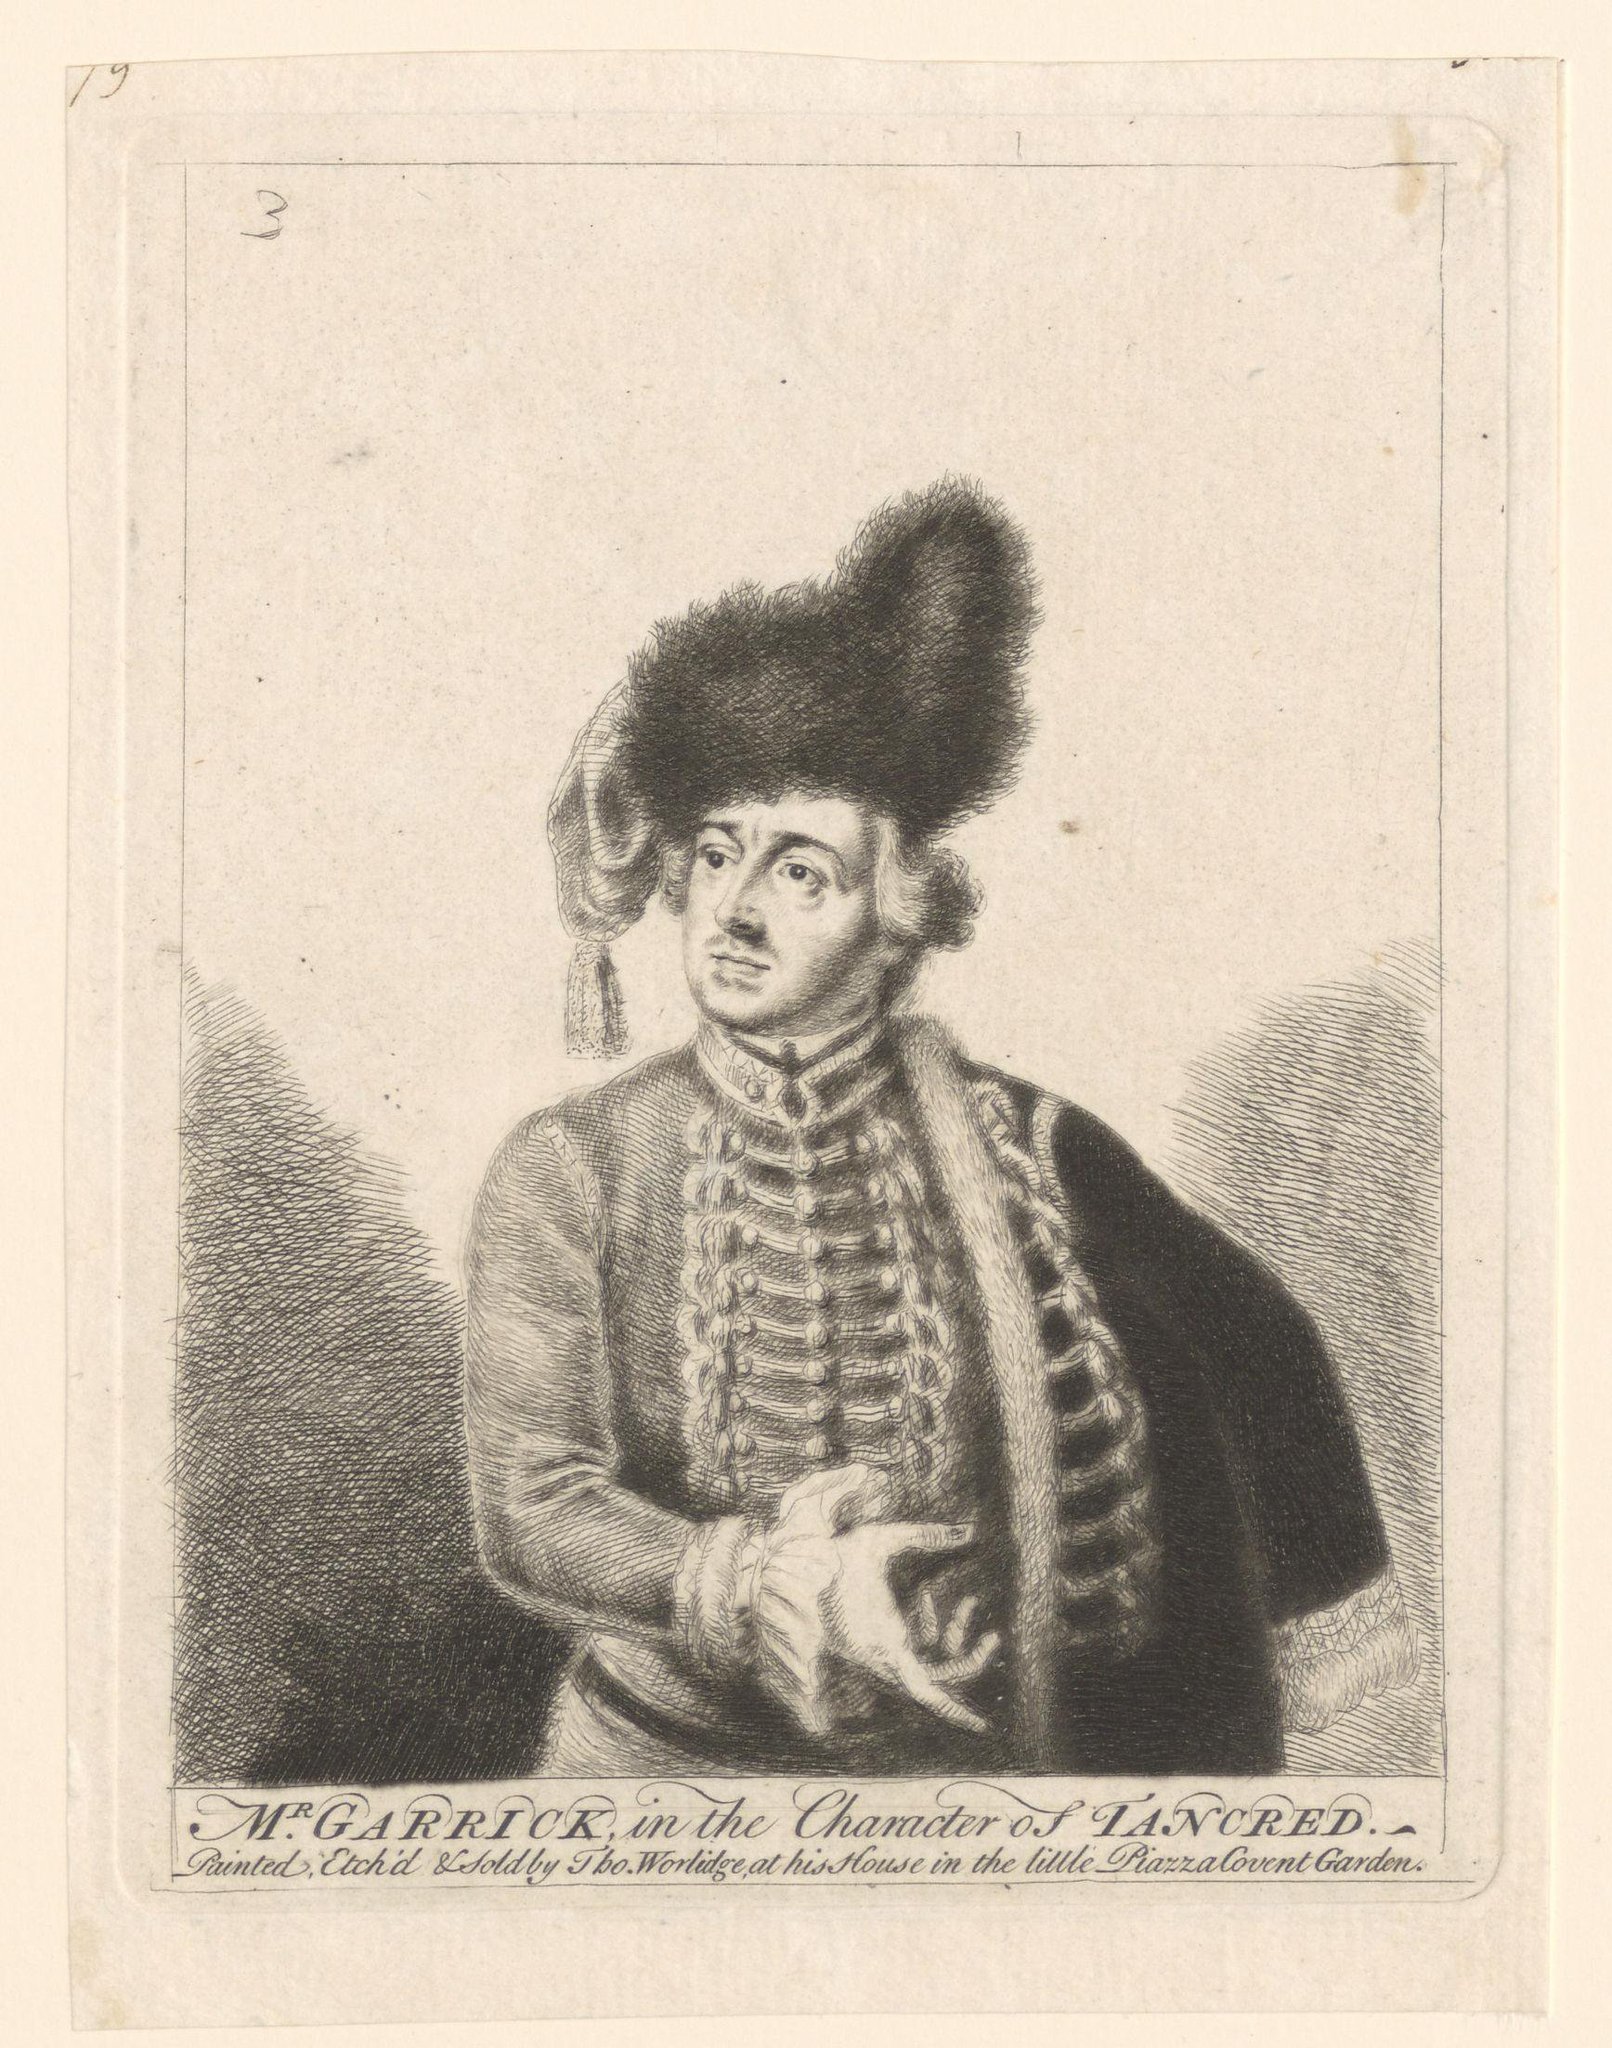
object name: print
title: Mr. Garrick in the Character of Tancred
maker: thomas worlidge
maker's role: print maker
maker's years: 1700-1766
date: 1754-1766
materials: paper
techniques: drypoint, etching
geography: london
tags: london, david garrick, james thomson (1700-1748), names of literary characters, historical person (...) - historical person (...) portrayed alone, portrait of actor, actress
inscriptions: collector's mark: Lugt 2228, collector's mark: Lugt 2760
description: Portret van David Garrick als het personage 'Tancred', uit James Thomsons 'Tancred en Sigismunda'.